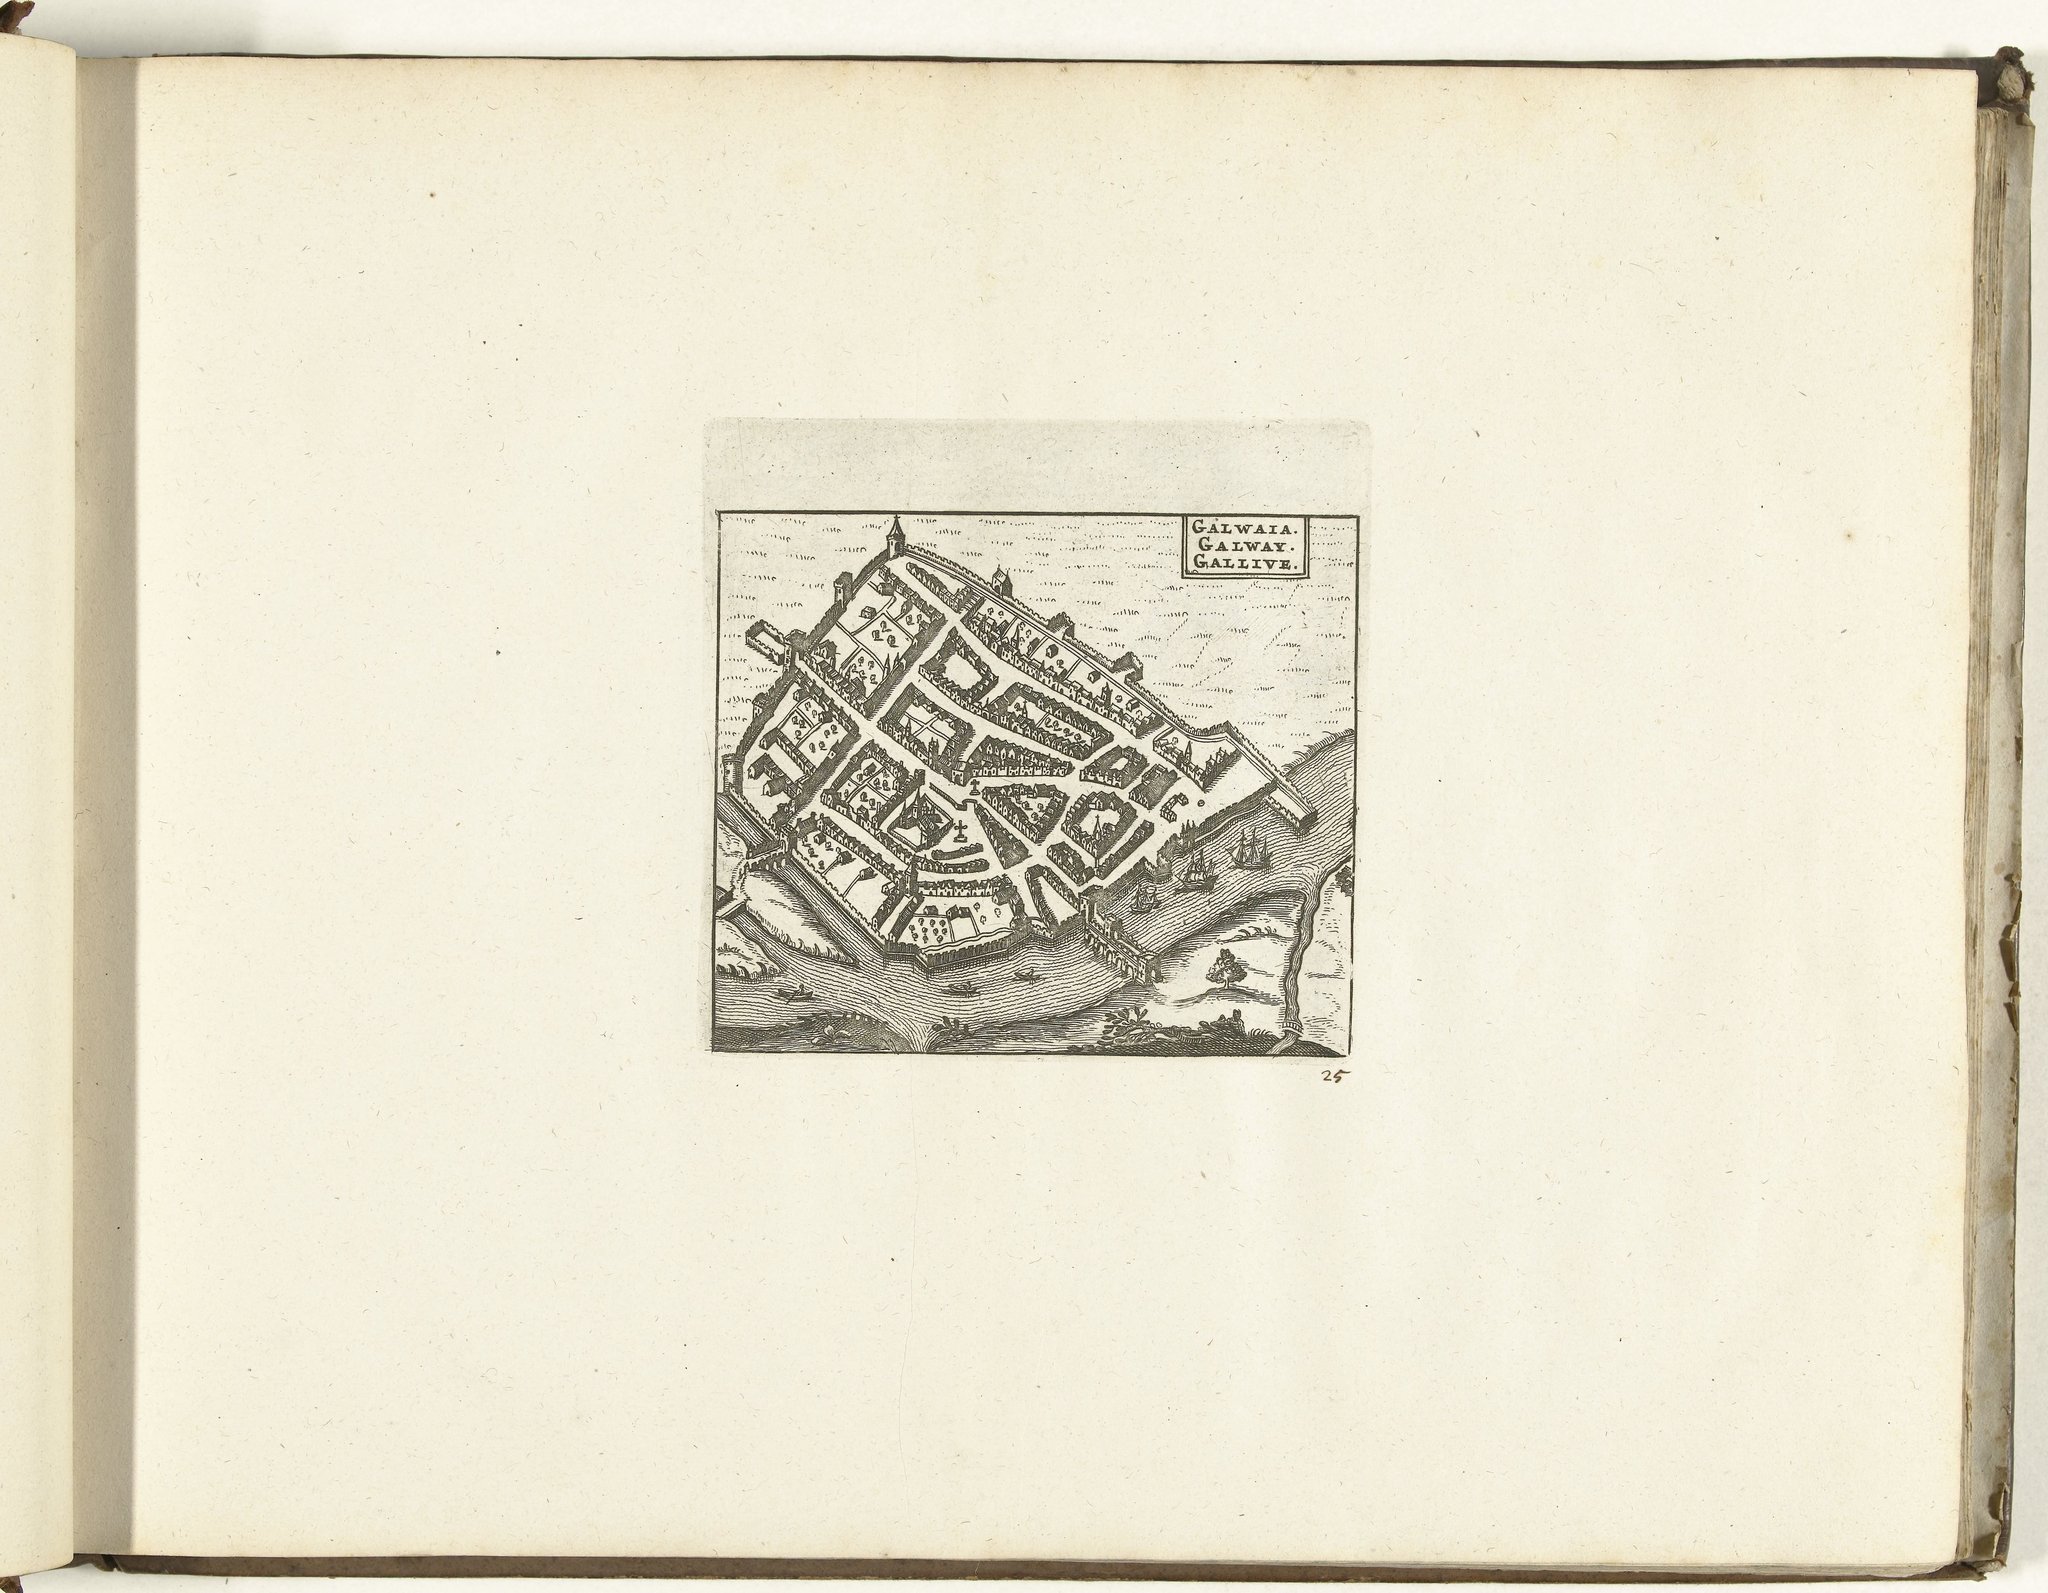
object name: print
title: Plattegrond van Galway, 1726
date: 1726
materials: paper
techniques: etching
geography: northern netherlands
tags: maps of cities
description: Plattegrond van Galway. Plaat nr. 25 in deel I van het prentwerk: Les Forces de l'Europe, Asie, Afrique et Amerique ... Comme aussi les Cartes des Côtes de France et d'Espagne uit 1726, dit eerste deel met 238 met de hand genummerde platen van vermaarde sterke steden en vestingen in het kader van de Spaanse Successieoorlog 1701-1713. Voor het merendeel zijn deze platen gekopieerd naar de anonieme Franse platen van vermaarde sterke steden en vestingen: in Les forces de l'Europe en in: Le theatre de la guerre, dans les Pays-Bas, beide oorspronkelijk uitgegeven door Nicolas de Fer te Parijs (1693-1697) in het kader van de Negenjarige Oorlog.